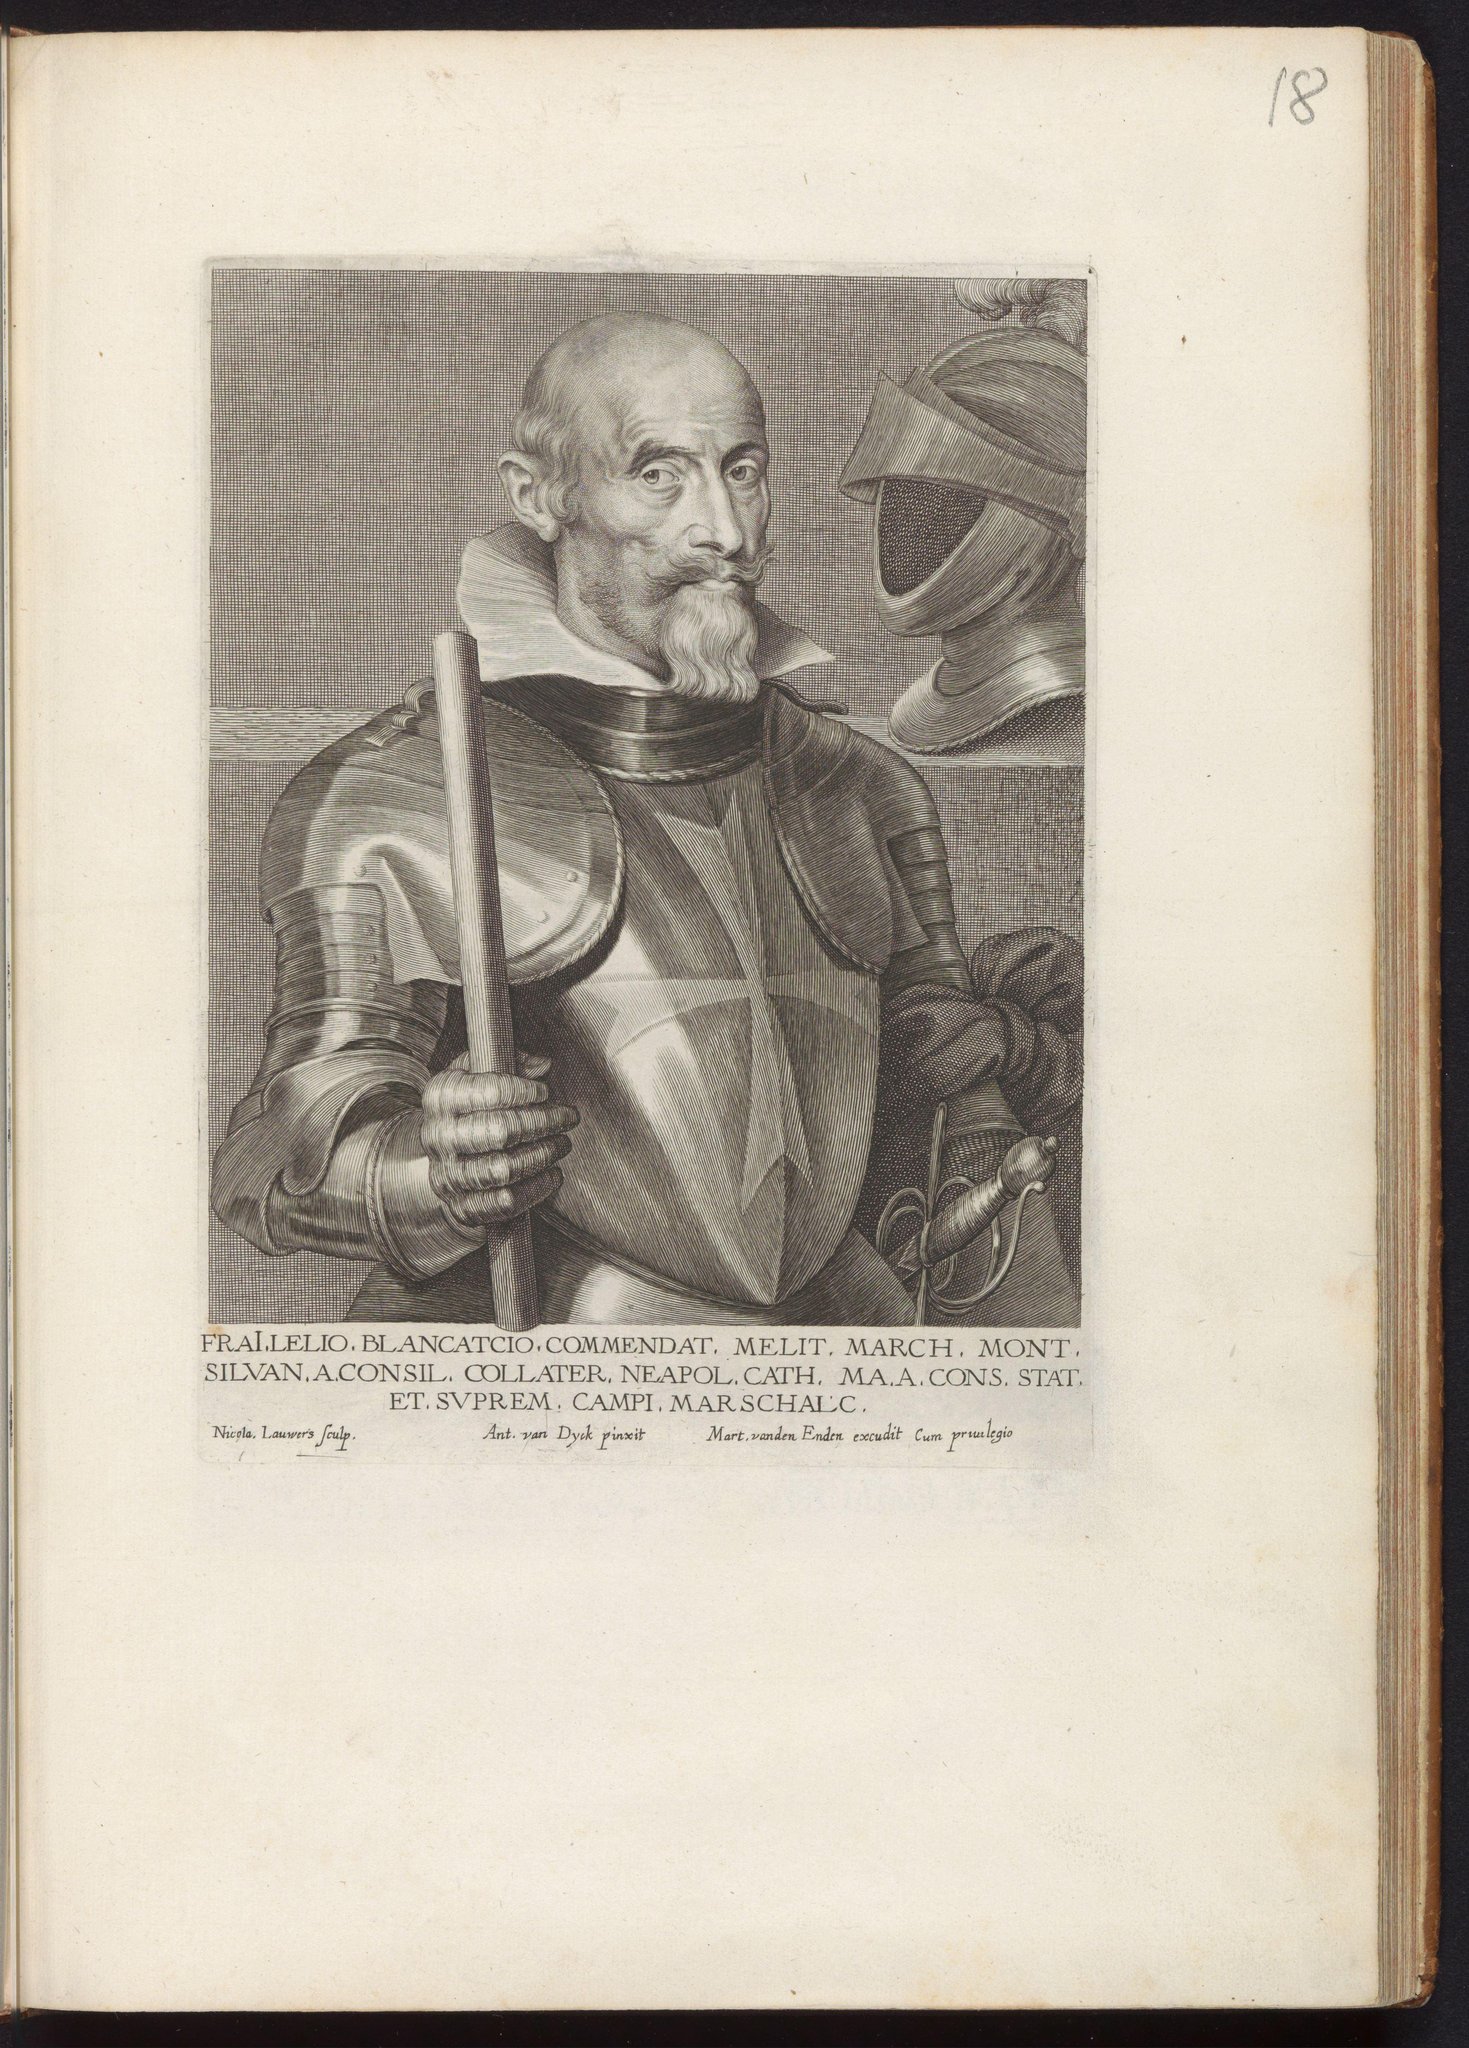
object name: print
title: Iconographie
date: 1630-1641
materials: paper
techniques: engraving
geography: antwerp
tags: armour, baton of general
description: Portret van Lelio Blancaccio, commandant van Malta. Blancaccio draagt een harnas met Maltezer kruis en houdt een commandostaf vast. Deze prent maakt deel uit van een album.